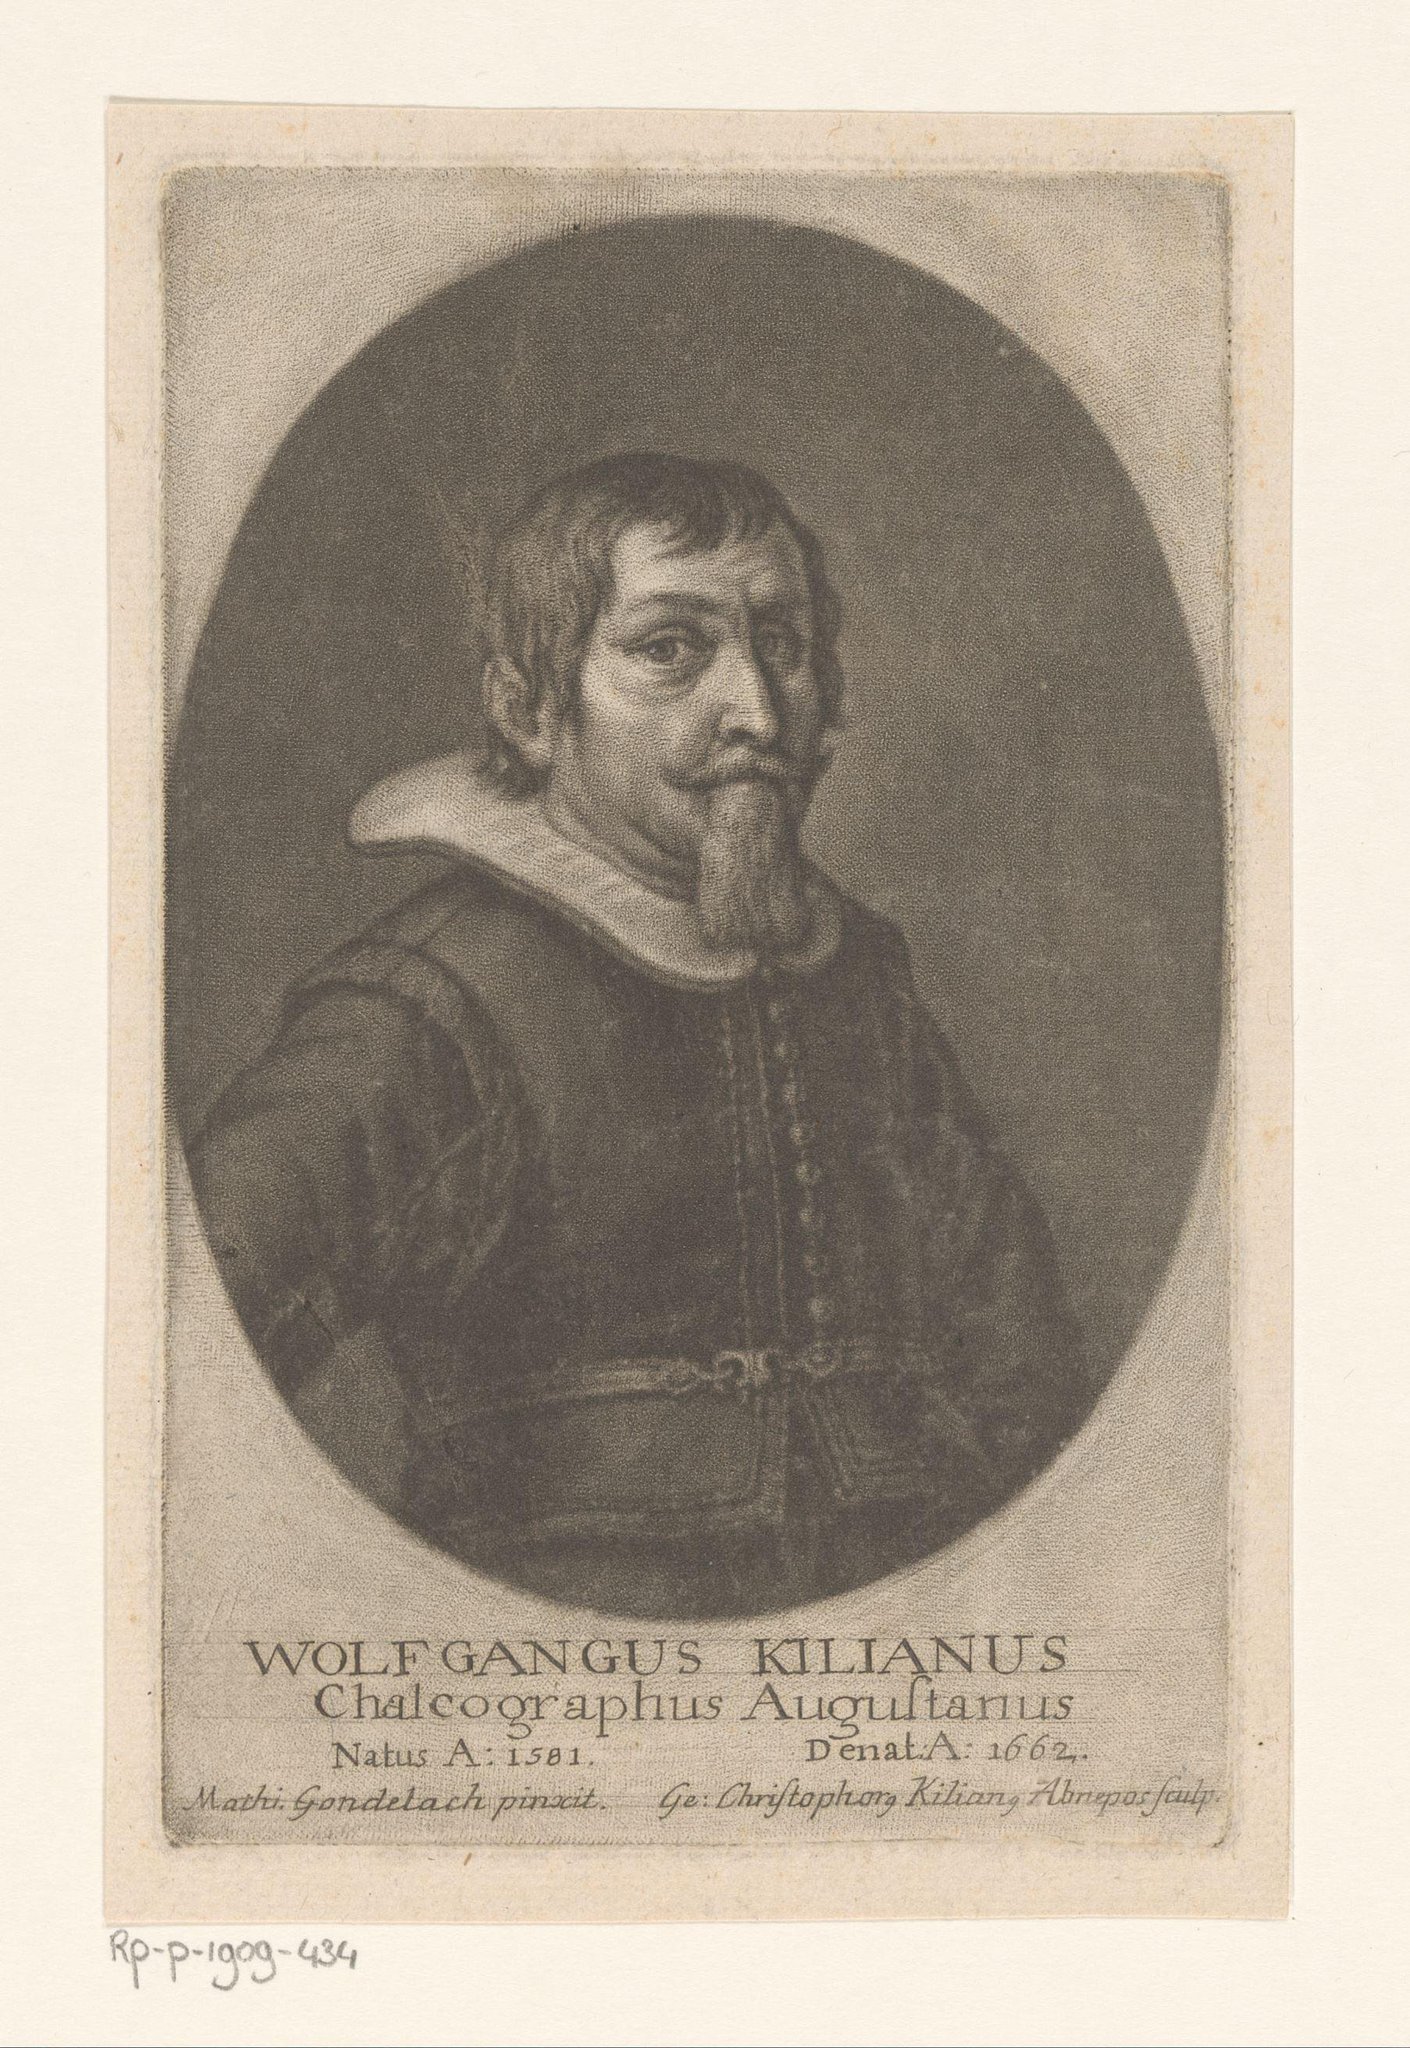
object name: print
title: Portret van Wolfgang Kilian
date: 1719-1781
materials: paper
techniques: mezzotint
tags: augsburg, print maker, wolfgang kilian, historical persons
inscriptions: collector's mark: Lugt 2228